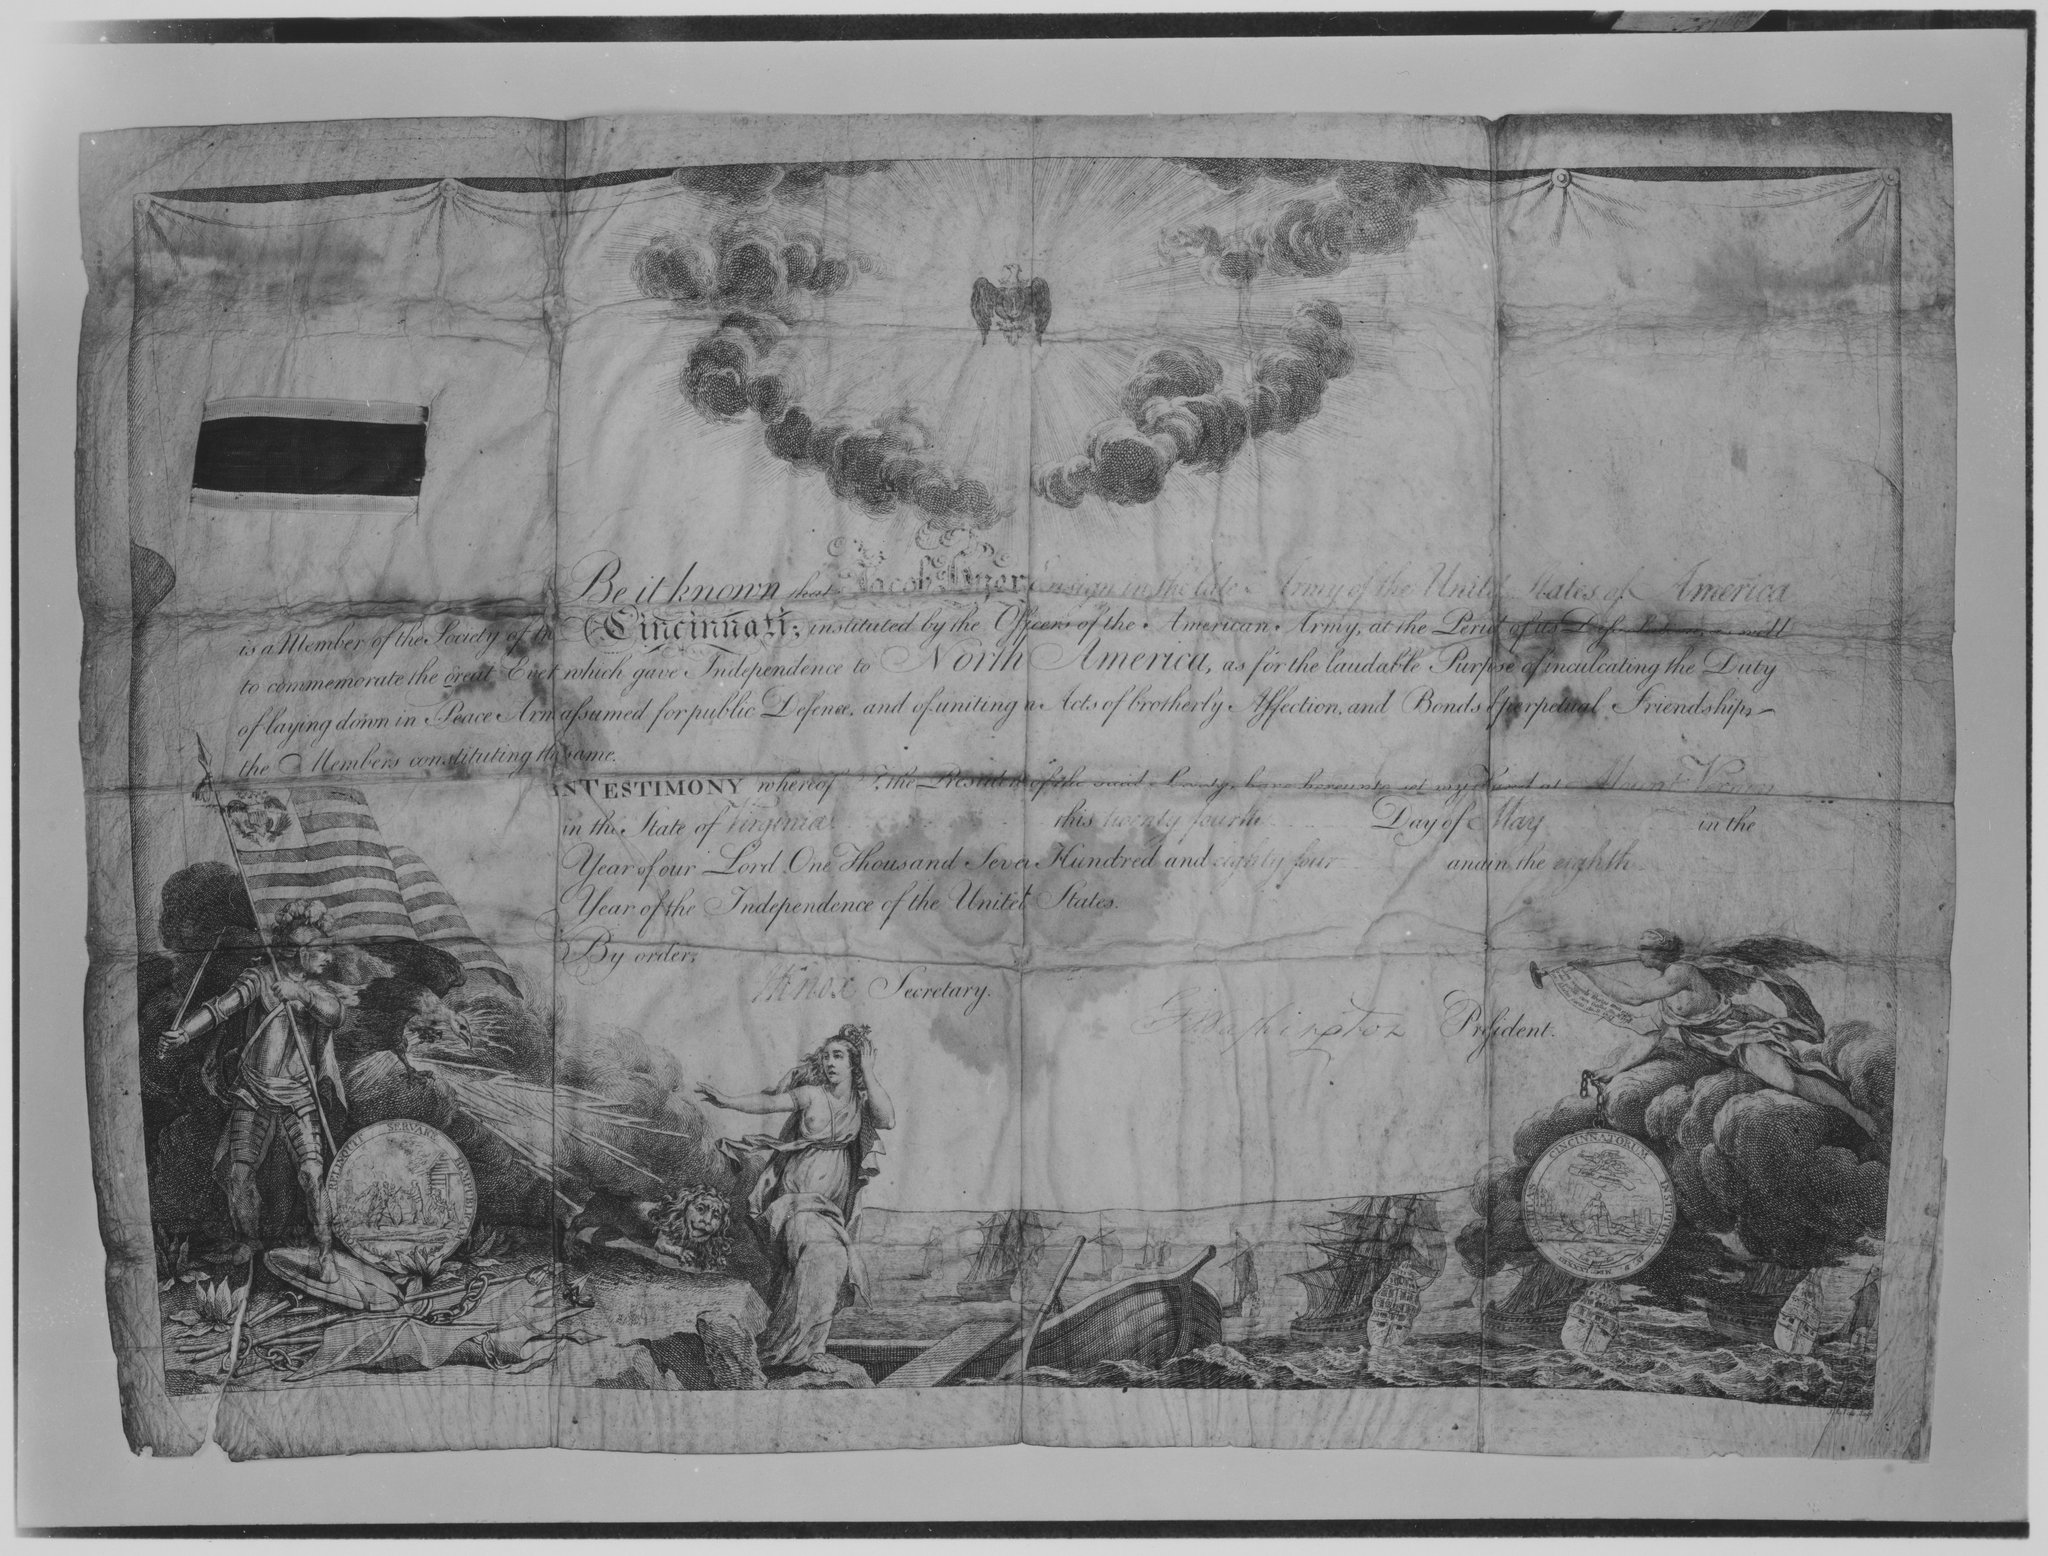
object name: print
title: Certificate of Membership in the Society of Cincinnati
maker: jean jacques le veau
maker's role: engraver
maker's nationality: french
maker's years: 1729-1786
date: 1784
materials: ribbon, parchment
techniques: engraving, printing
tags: american revolution,documents